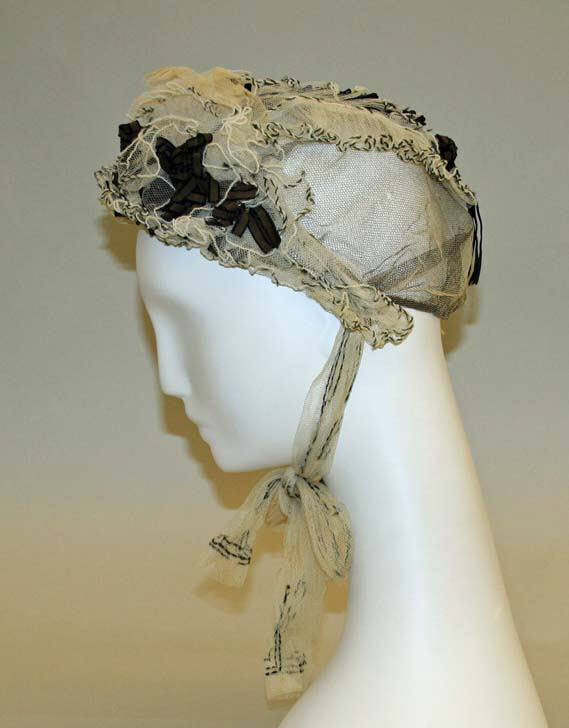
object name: cap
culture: american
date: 1863-1865